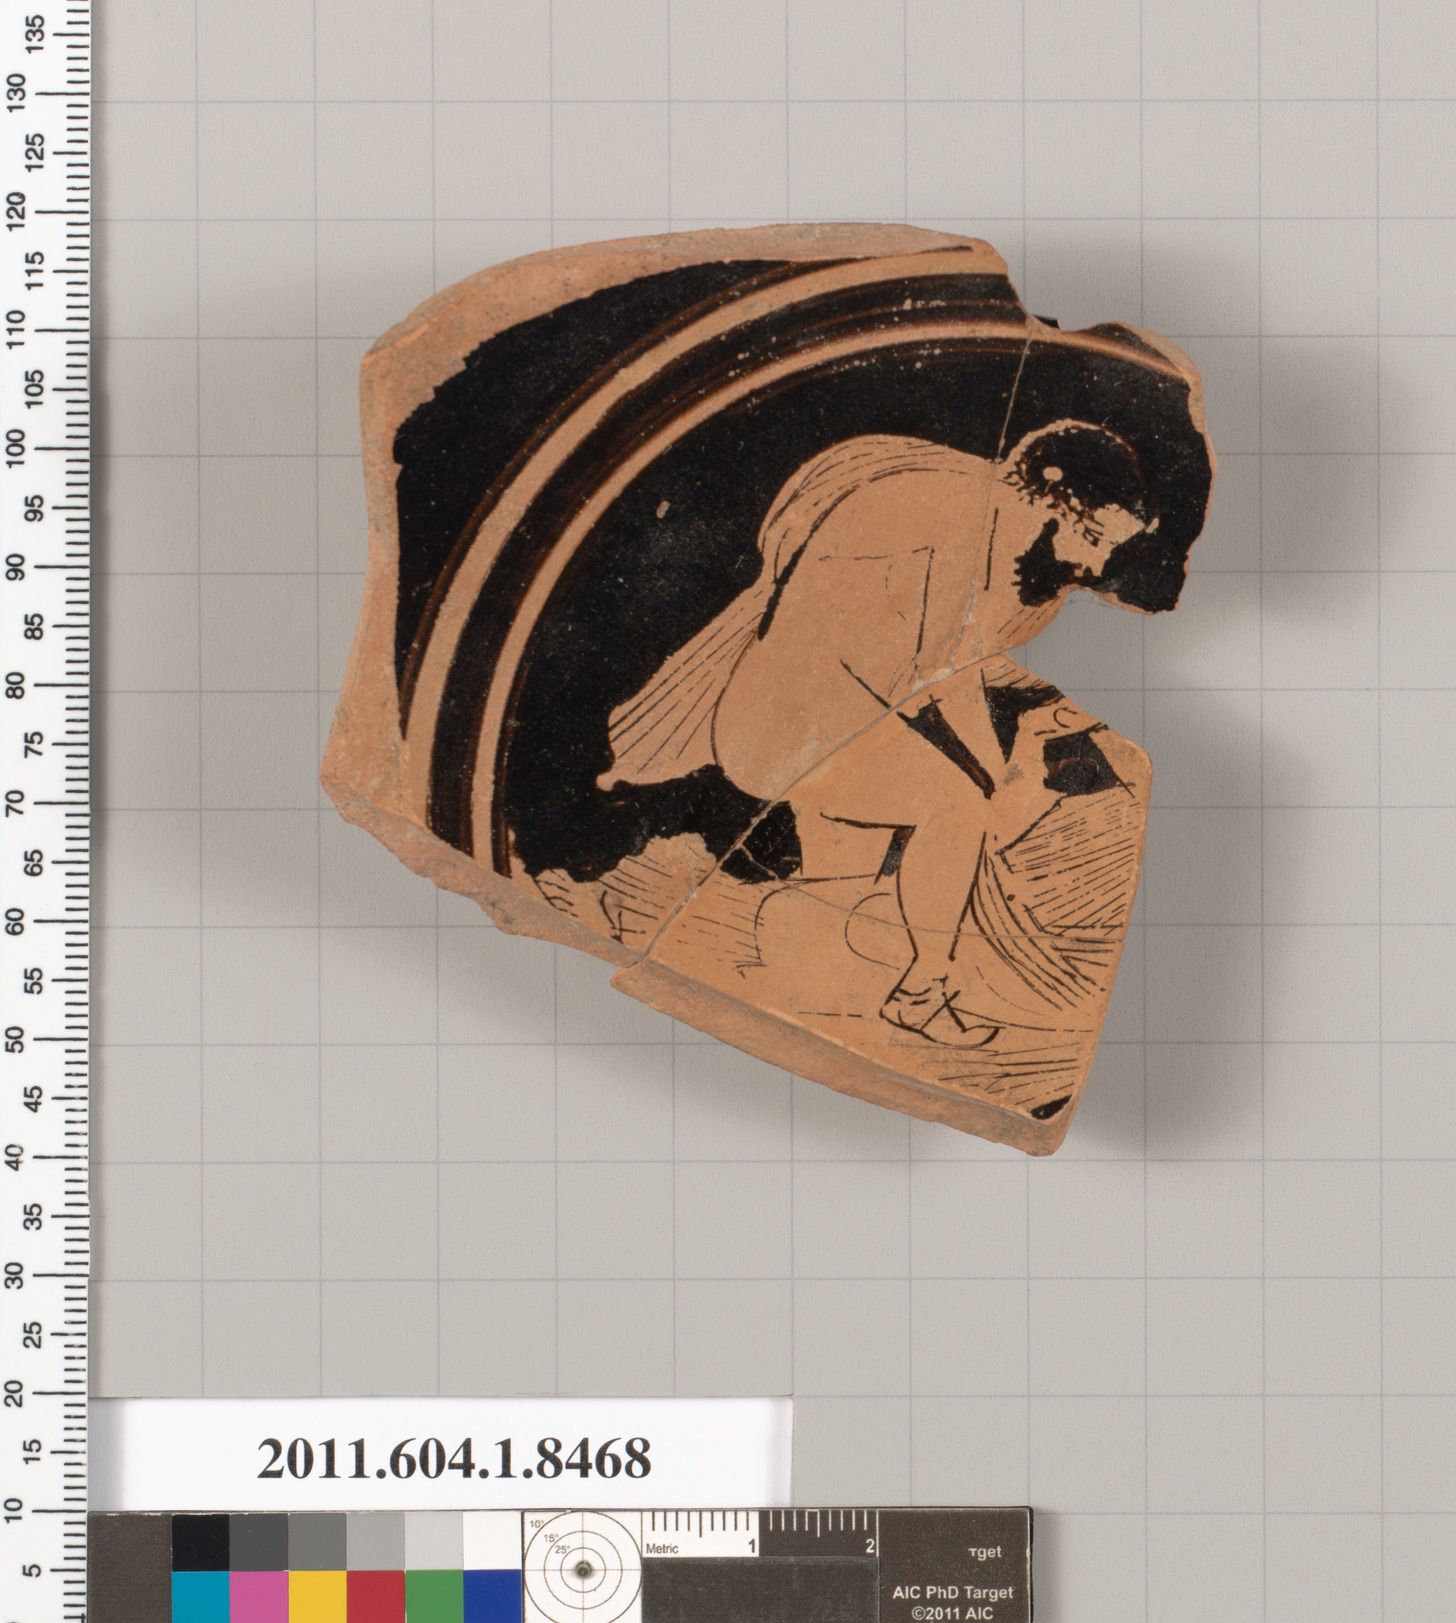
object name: kylix fragment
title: Terracotta fragment of a stemless kylix (drinking cup)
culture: greek, attic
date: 460-450 BCE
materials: terracotta